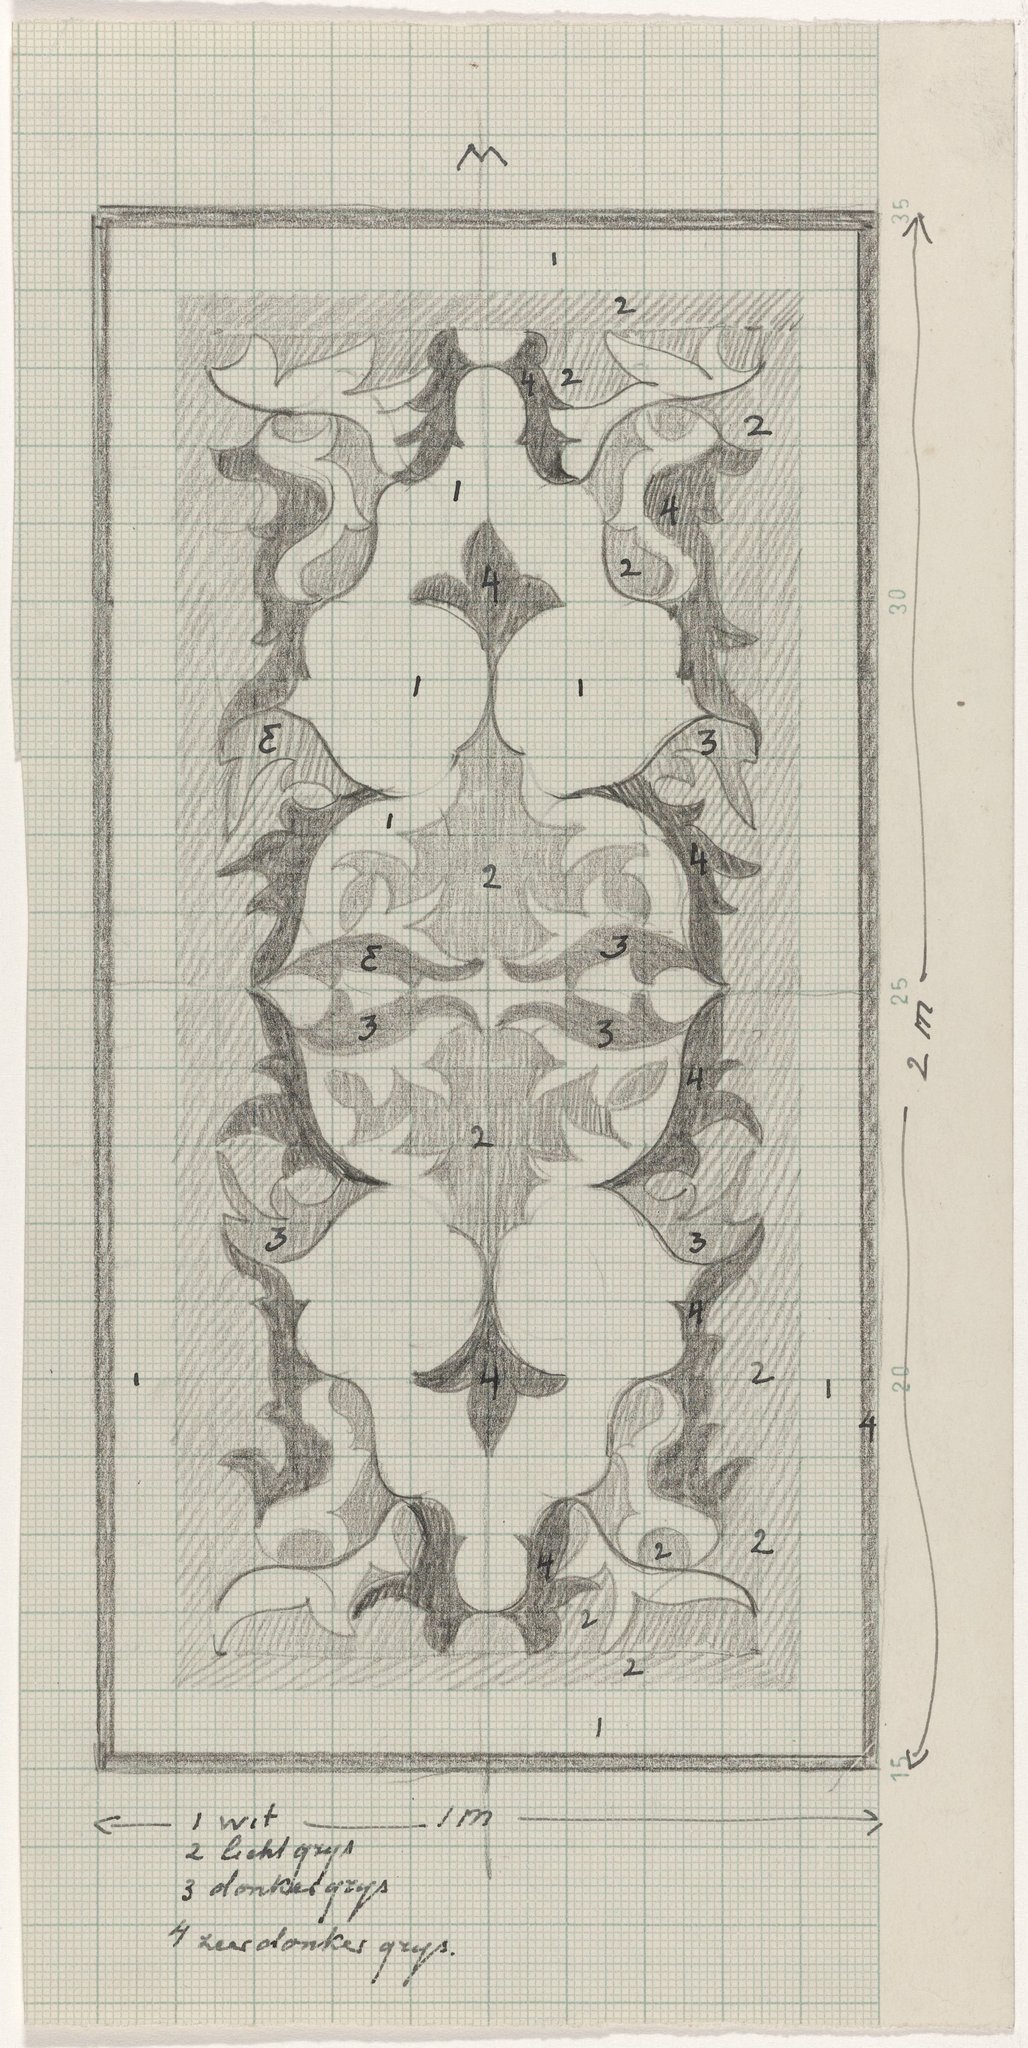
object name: drawing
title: Decoratief ontwerp met kleuraanduidingen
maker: carel adolph lion cachet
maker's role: draughtsman, print maker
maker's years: 1864-1945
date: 1874-1945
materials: pencil